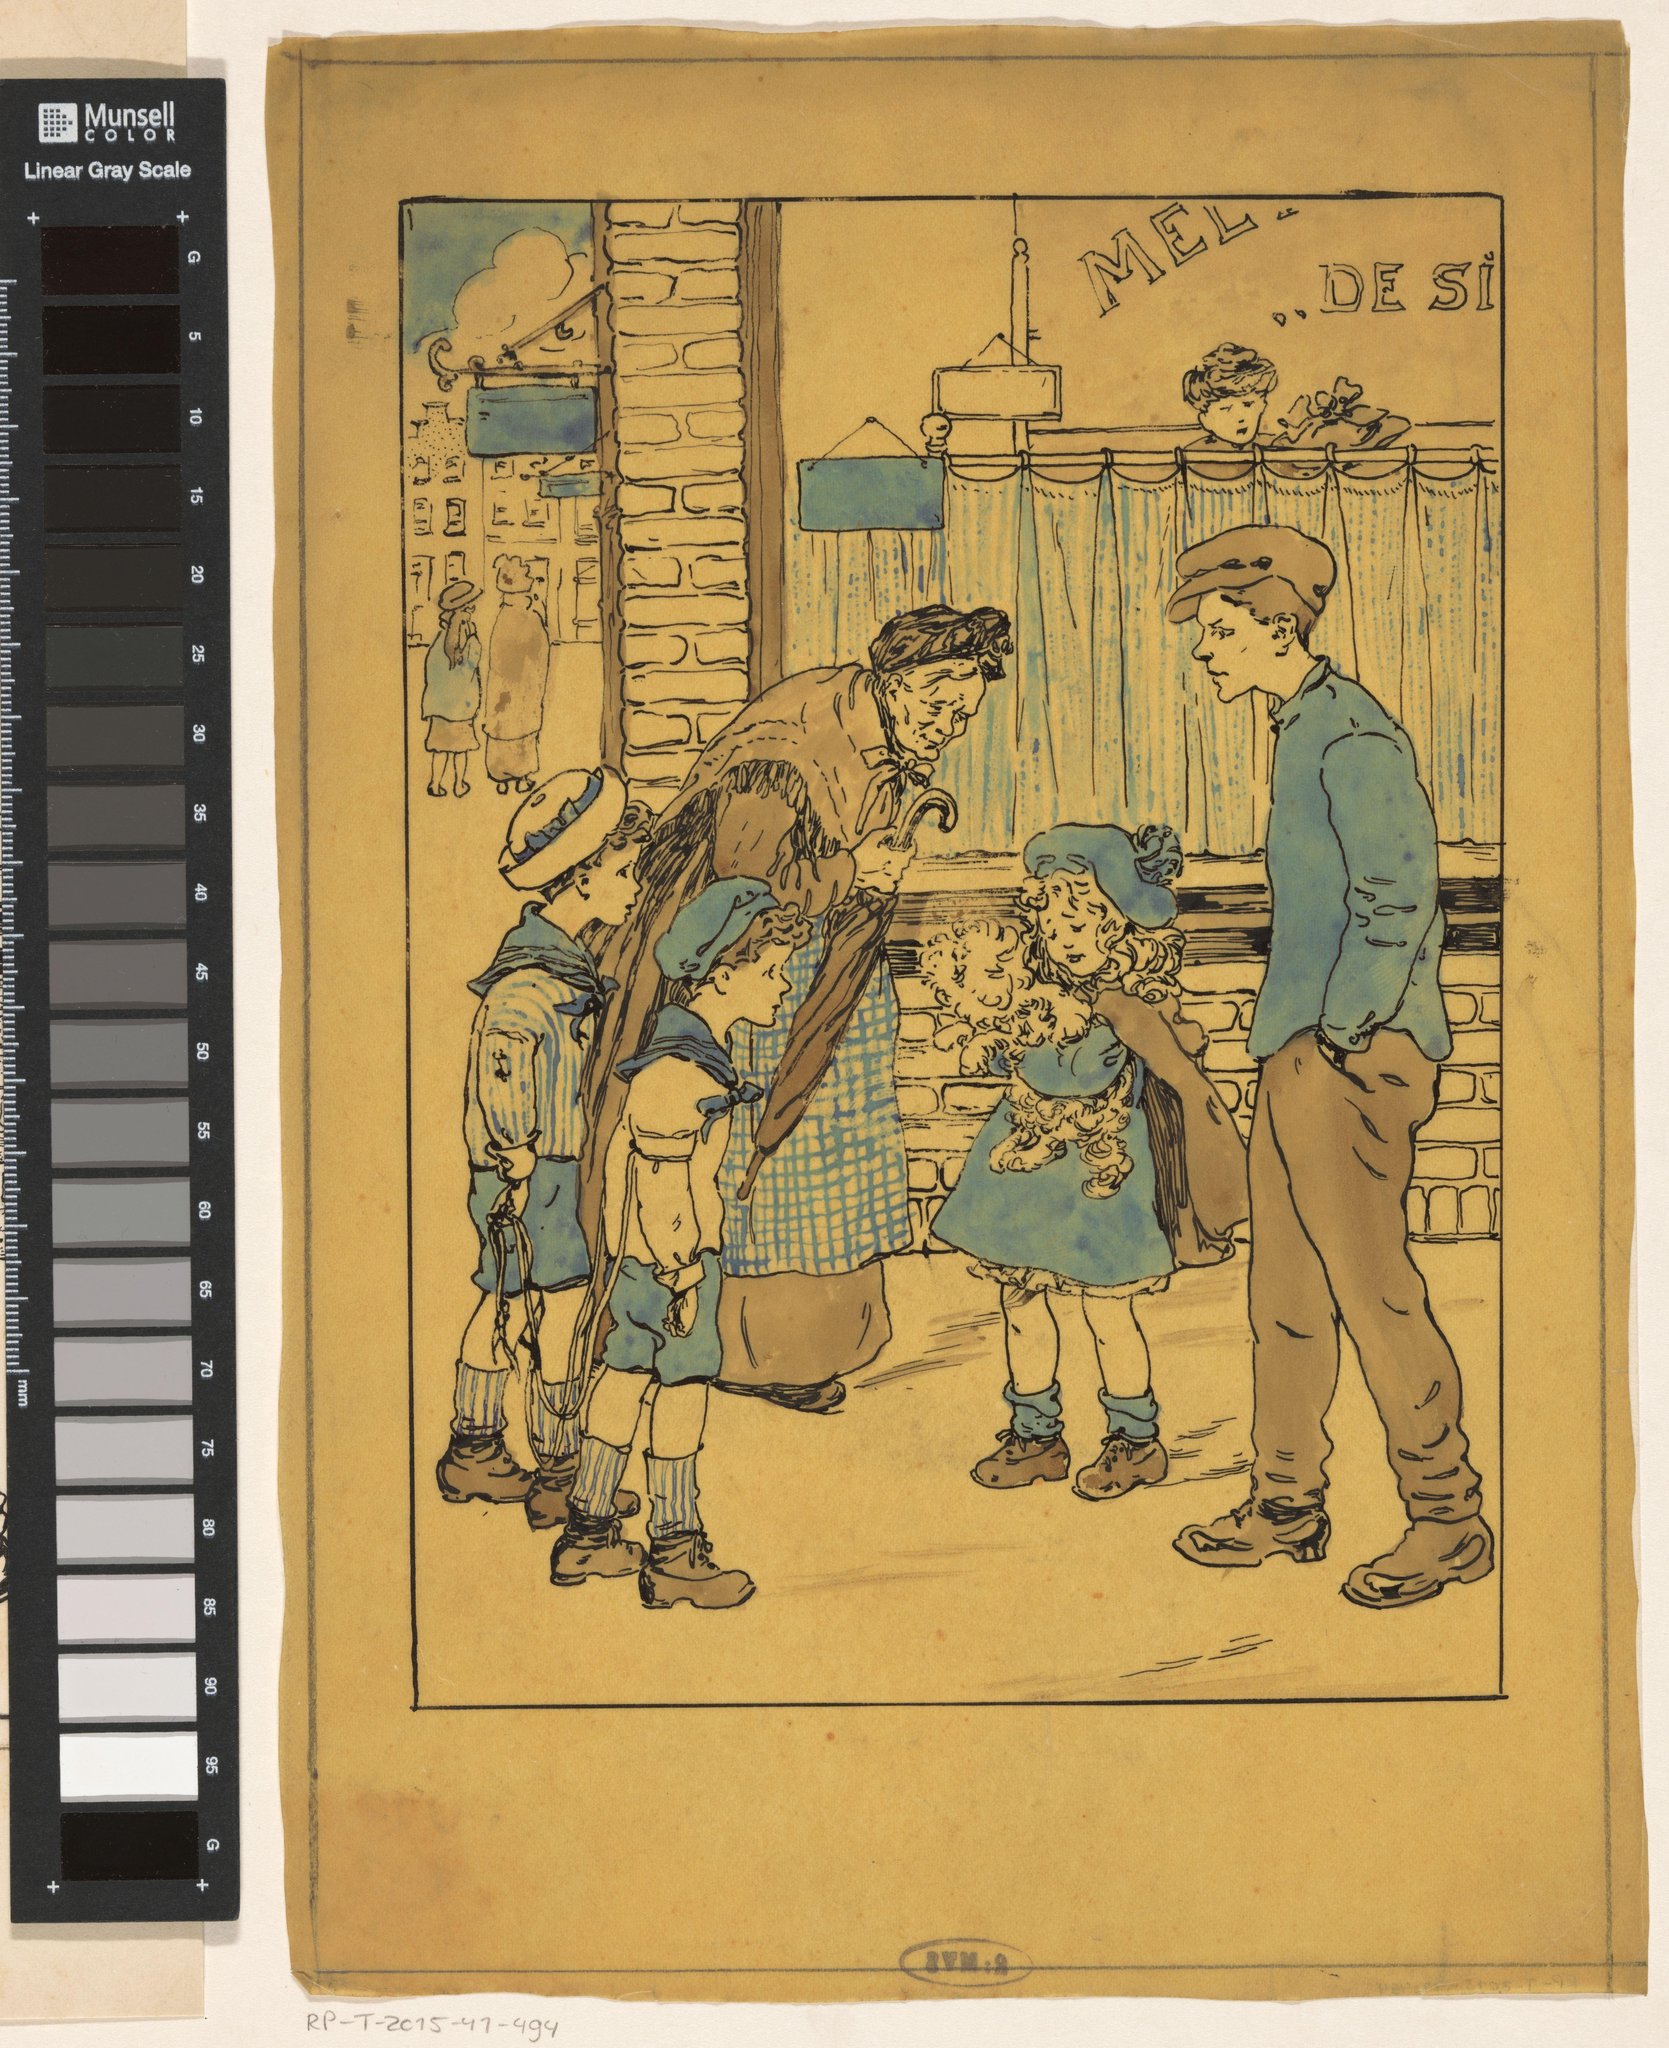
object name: boekillustratie ontwerp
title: Meisje met hond op een straathoek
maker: nelly spoor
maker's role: draughtsman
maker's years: 1885-1950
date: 1915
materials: ink, paper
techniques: brush, pen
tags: girl (child between toddler and youth), dog, street (+ city(-scape) with figures, staffage), shop-window, show-window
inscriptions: collector's mark: Lugt 2228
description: Een meisje staat op een straathoek voor de etalage van een melkwinkel. Ze heeft een hond in haar armen. Een oude vrouw met paraplu, een jongeman en twee jongens passeren het meisje.